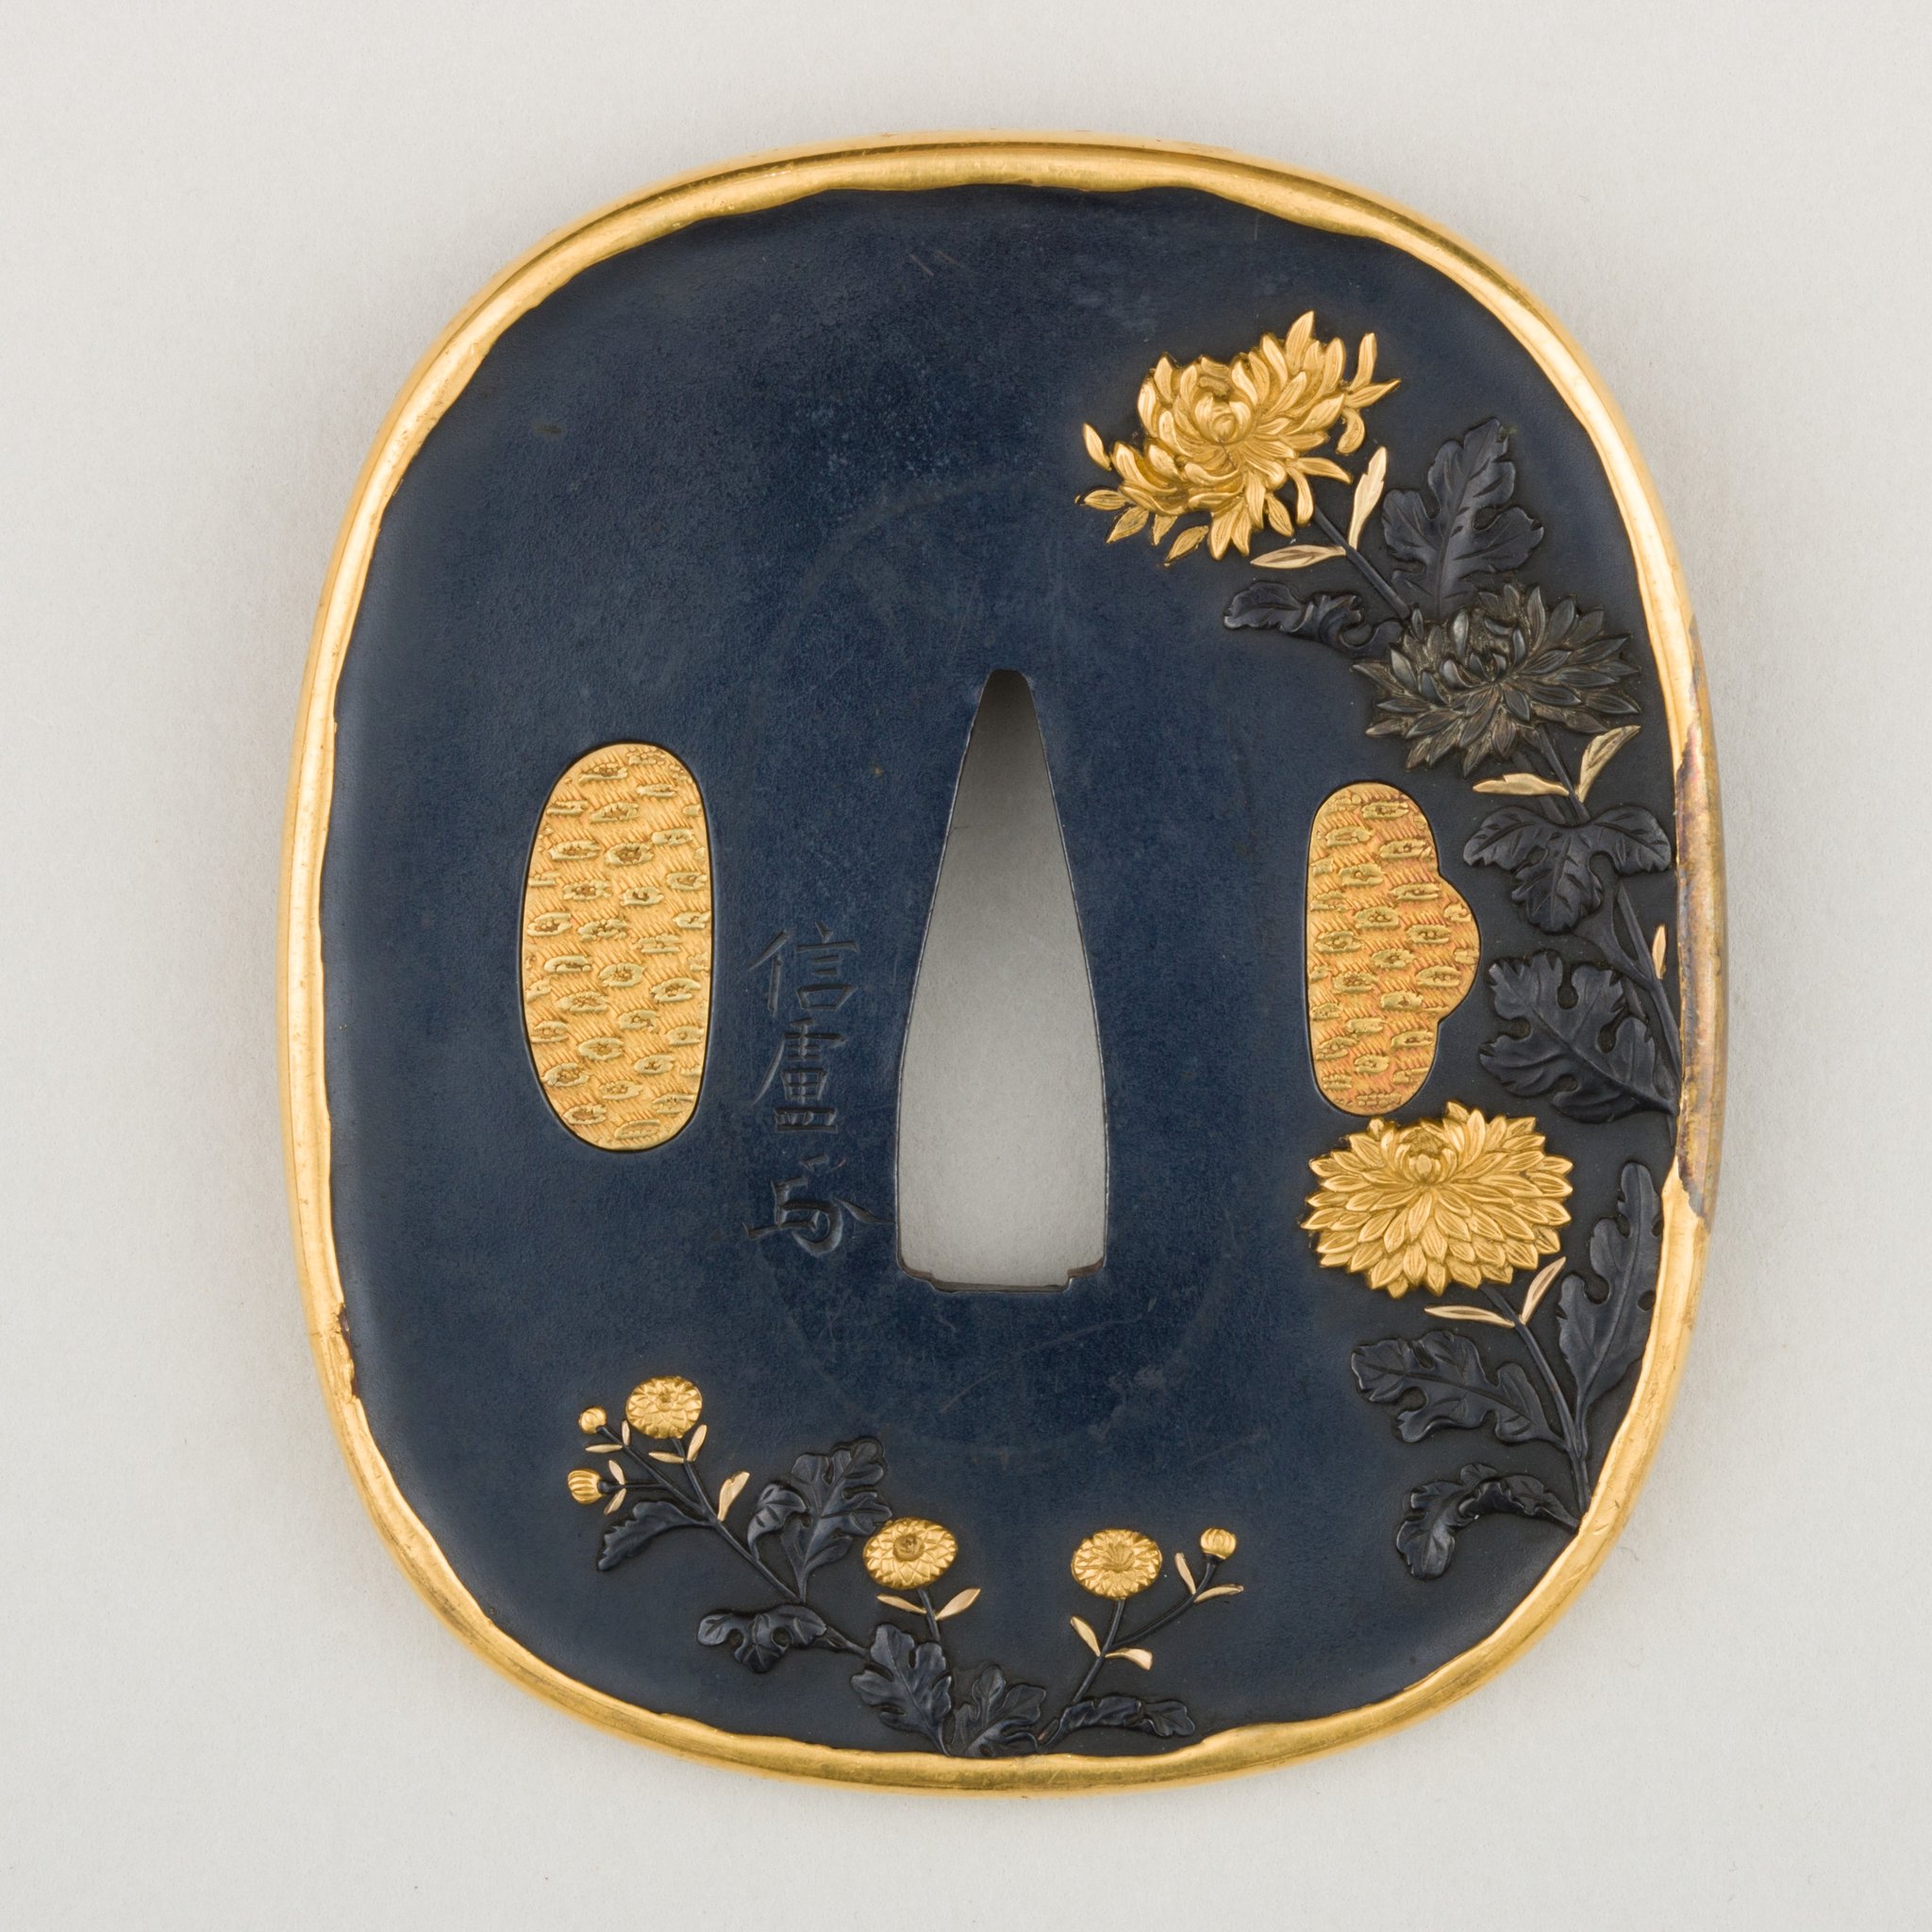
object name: sword guard tsuba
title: Sword Guard (Tsuba)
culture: japanese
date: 1801-1900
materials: copper, gold alloy, gold, silver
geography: japan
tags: flowers